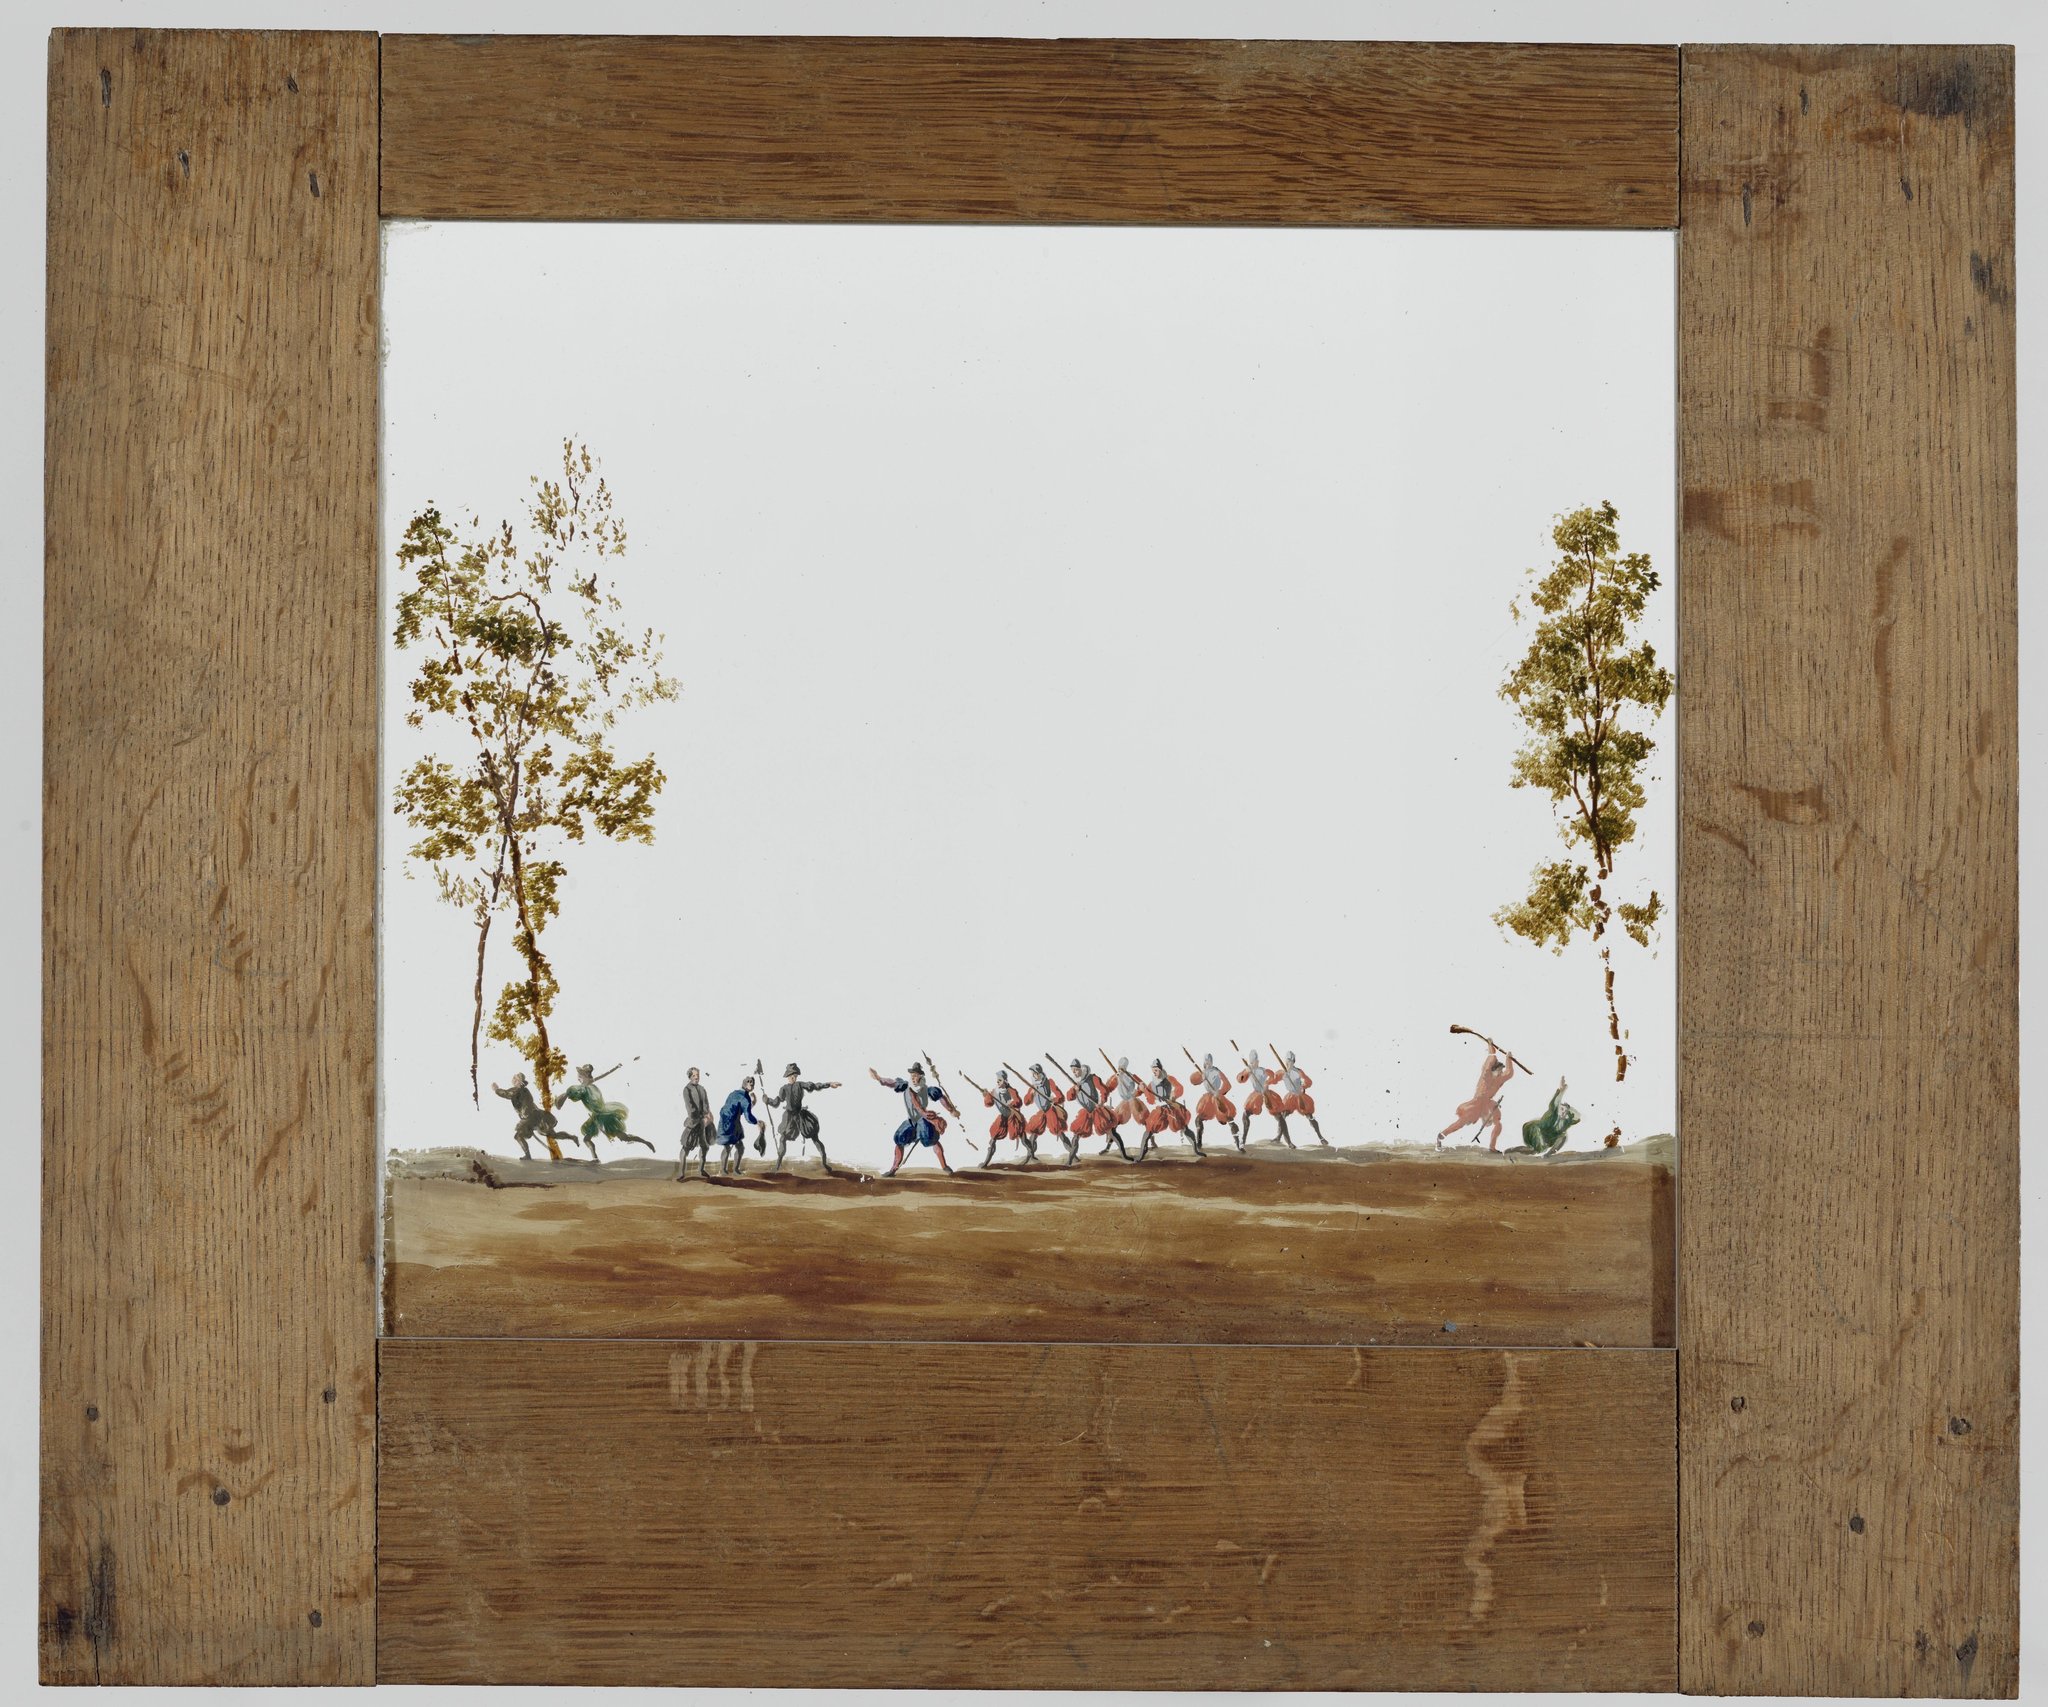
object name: diafanoramaplaat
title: Tweezijdig diafanorama van een veldslag uit de zeventiende eeuw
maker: Anonymous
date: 1750-1830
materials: glass, wood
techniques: painted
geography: netherlands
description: Op de afbeelding zijn zestien mannen zichtbaar (van links naar rechts) en twee bomen. De 1e persoon draagt bruine kleren en vlucht. De 2e persoon draagt groene kleren en vlucht ook.. De 3e, 4e en 5e persoon dragen allen zwarte kleren en voeren overleg. De 6e persoon draagt een soort van officierskleding en strekt zijn armen uit naar 3,4 5 en 5. De 7e tot en met de 14e persoon dragen rood-grijse kleren en hebben hun geweer in de aanslag. De 15e persoon draagt roze kleren en wil nummer 16 neerslaan. De 16e persoon draagt groene kleren en houdt zijn armen ter bescherming van boven zijn hoofd. Voorkant = persoon 3 tot en met 9 en 11. Achterkant = persoon 1,2, 10 en 12 tot en met 16.